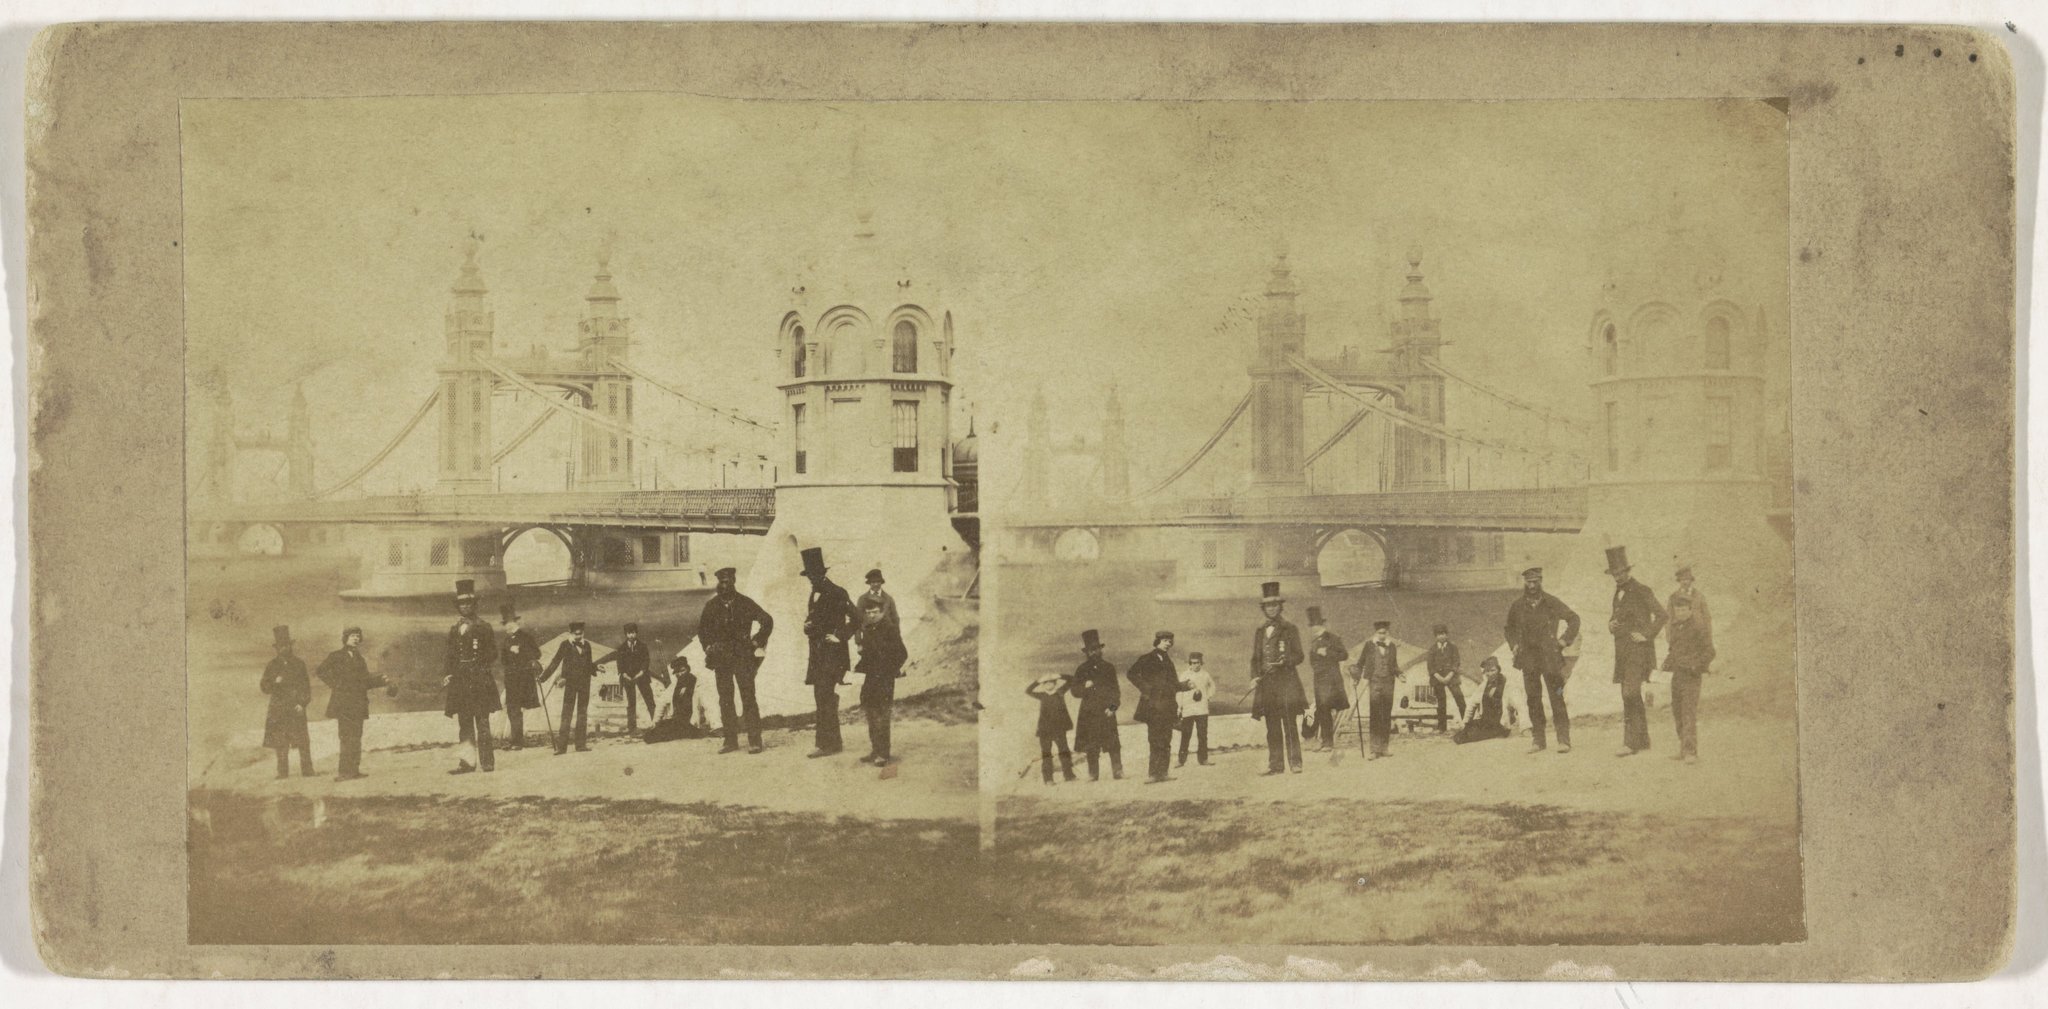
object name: stereograph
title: Groep mannen met op de achtergrond vermoedelijk Battersea Suspension Bridge, Londen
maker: Anonymous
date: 1850-1870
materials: photographic support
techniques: albumen print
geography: london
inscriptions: annotation: ‘Nummer (?) k J. (?) 18’